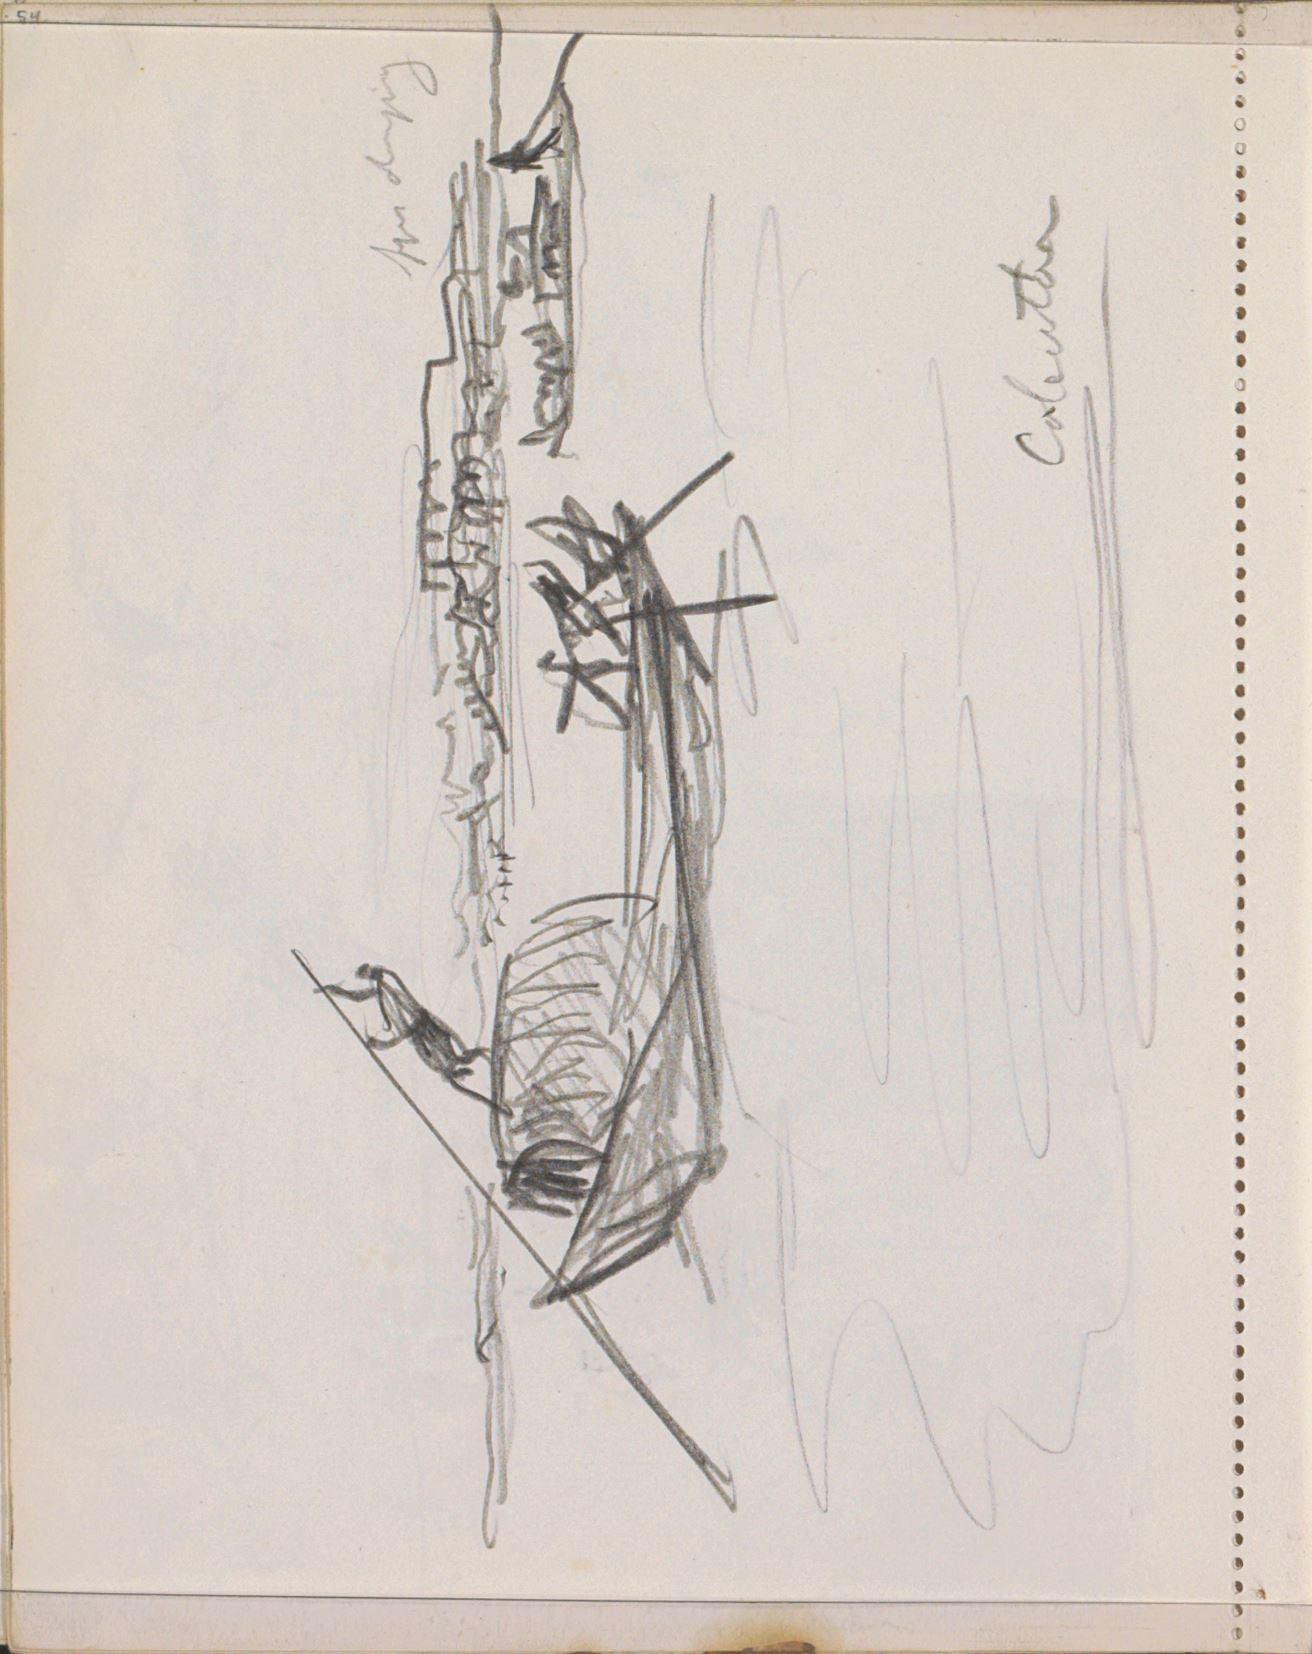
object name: sketchbook leaf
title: Roeiboten op de Hooghly rivier bij Calcutta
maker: marius bauer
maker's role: draughtsman, print maker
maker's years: 1867-1932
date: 1924-1925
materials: paper, pencil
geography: kolkata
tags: river, landscapes with waters, waterscapes, seascapes (in the temperate zone), rowing-boat, canoe, etc.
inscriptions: annotation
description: Pagina 54 uit een schetsboek met 75 bladen.